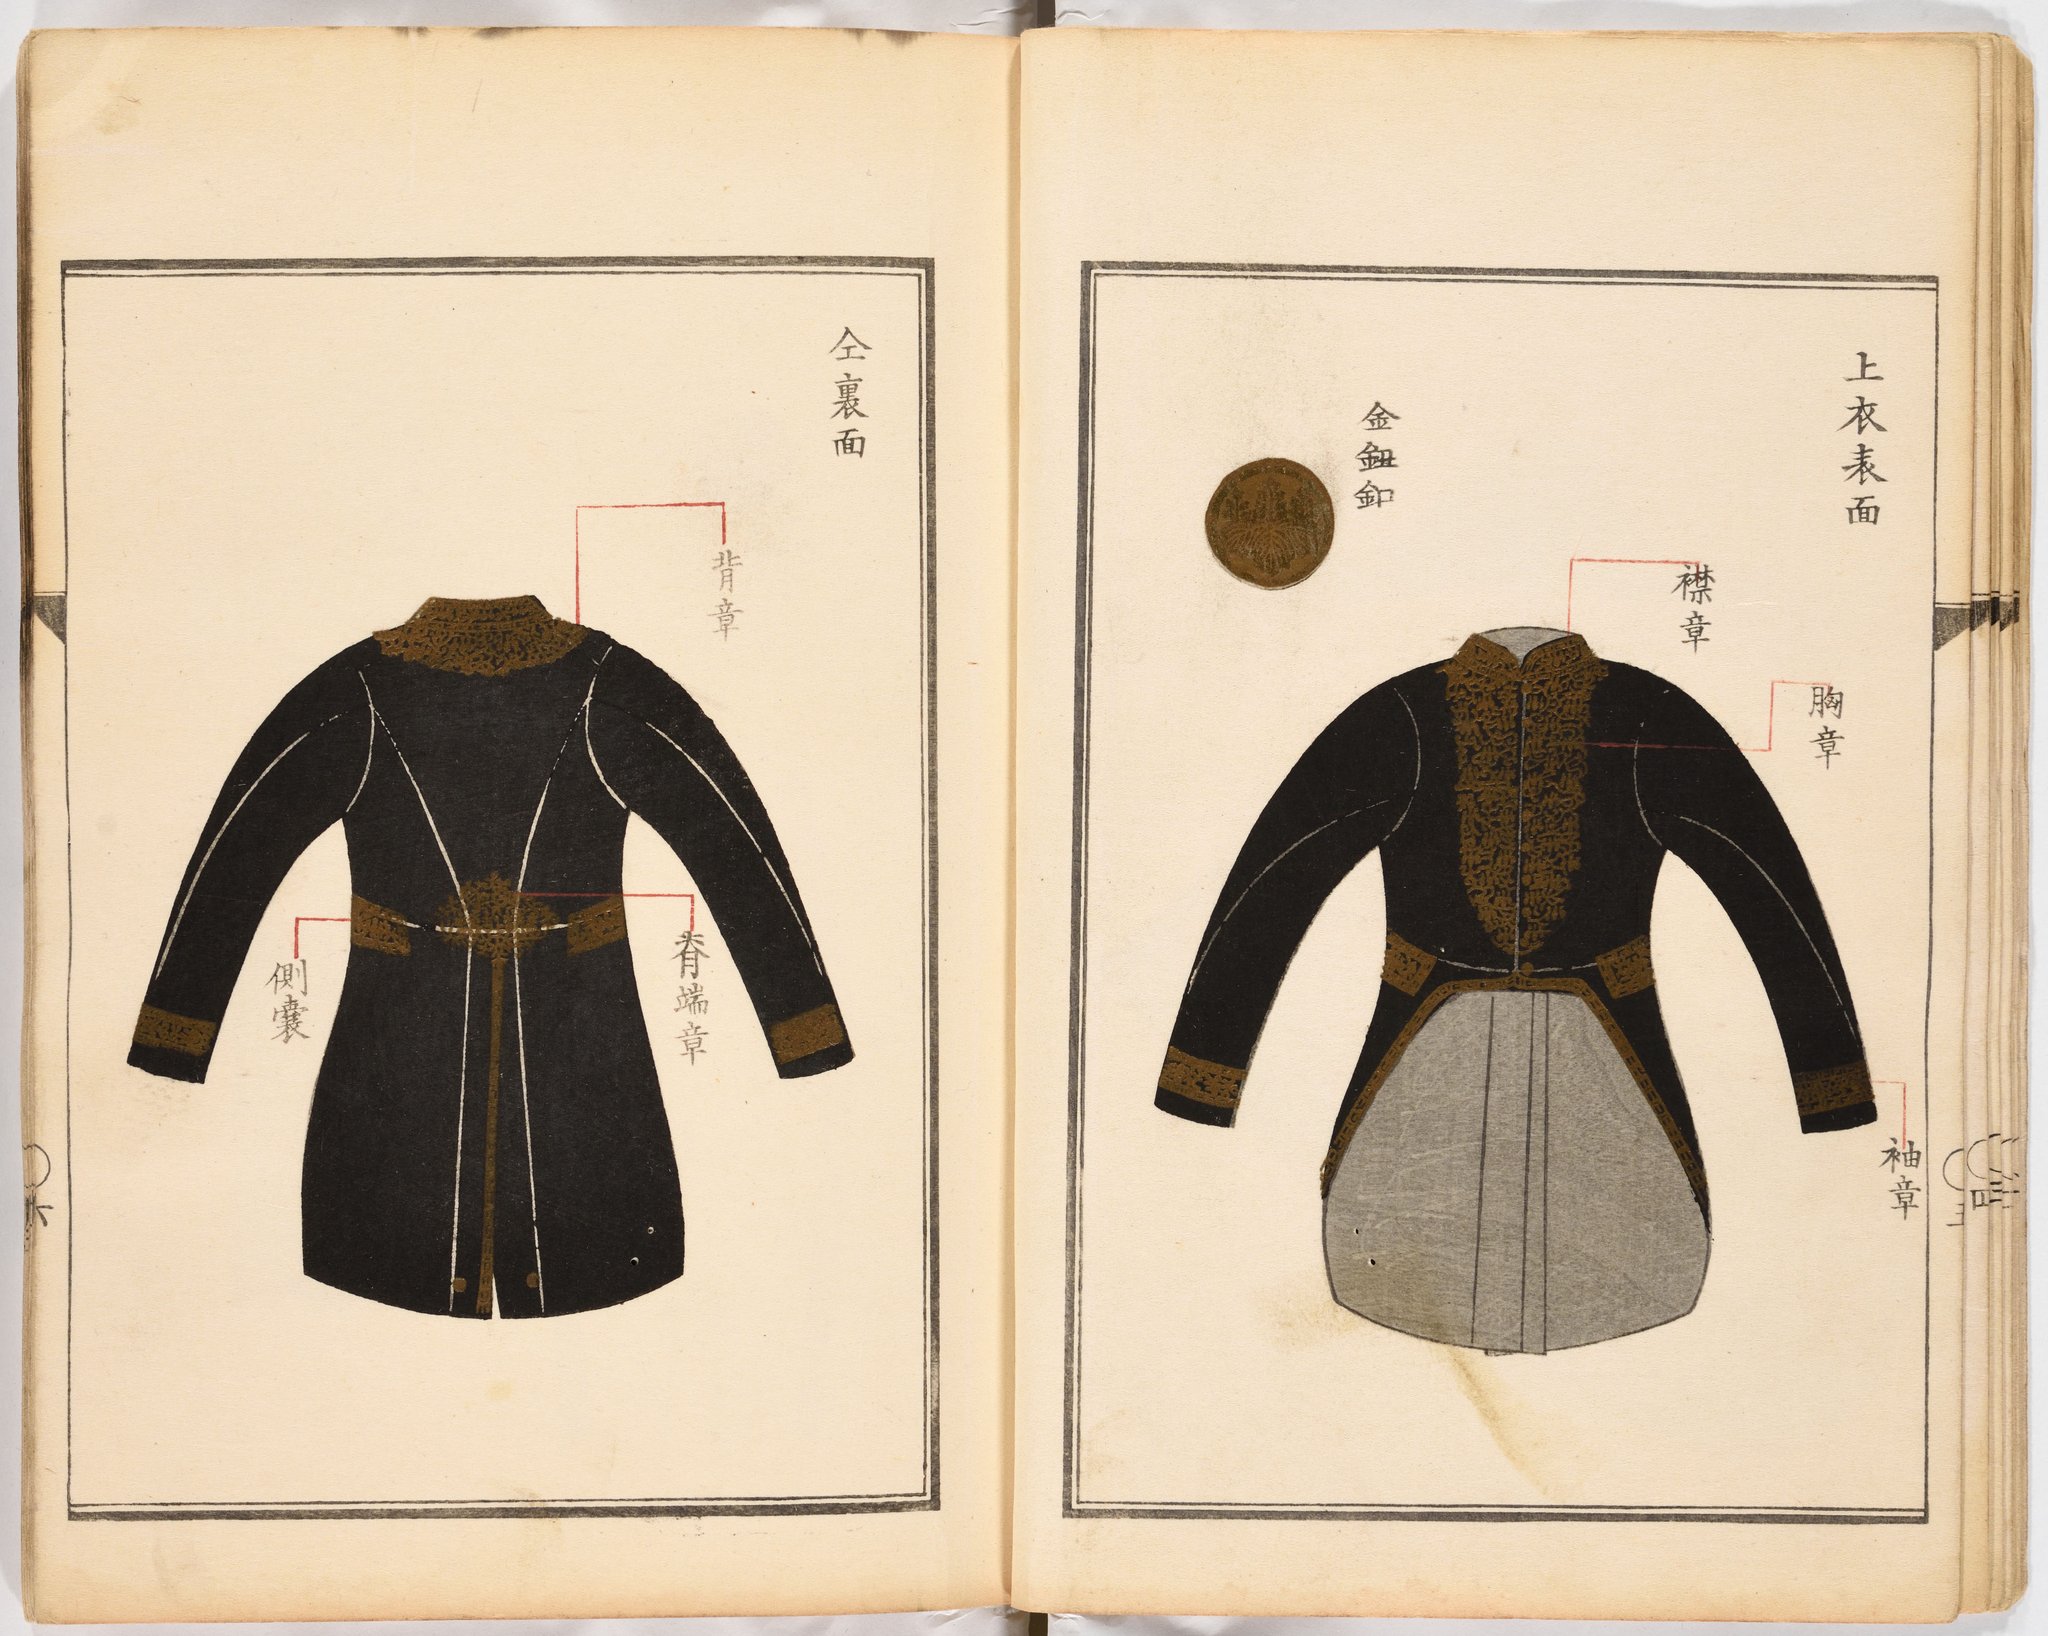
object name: illustrated book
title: Dai fukusei hyōizu (Illustrated Manual of Men’s Formal Court Uniform Making)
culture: japanese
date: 1893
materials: gold, ink, paper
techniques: woodblock print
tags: suits